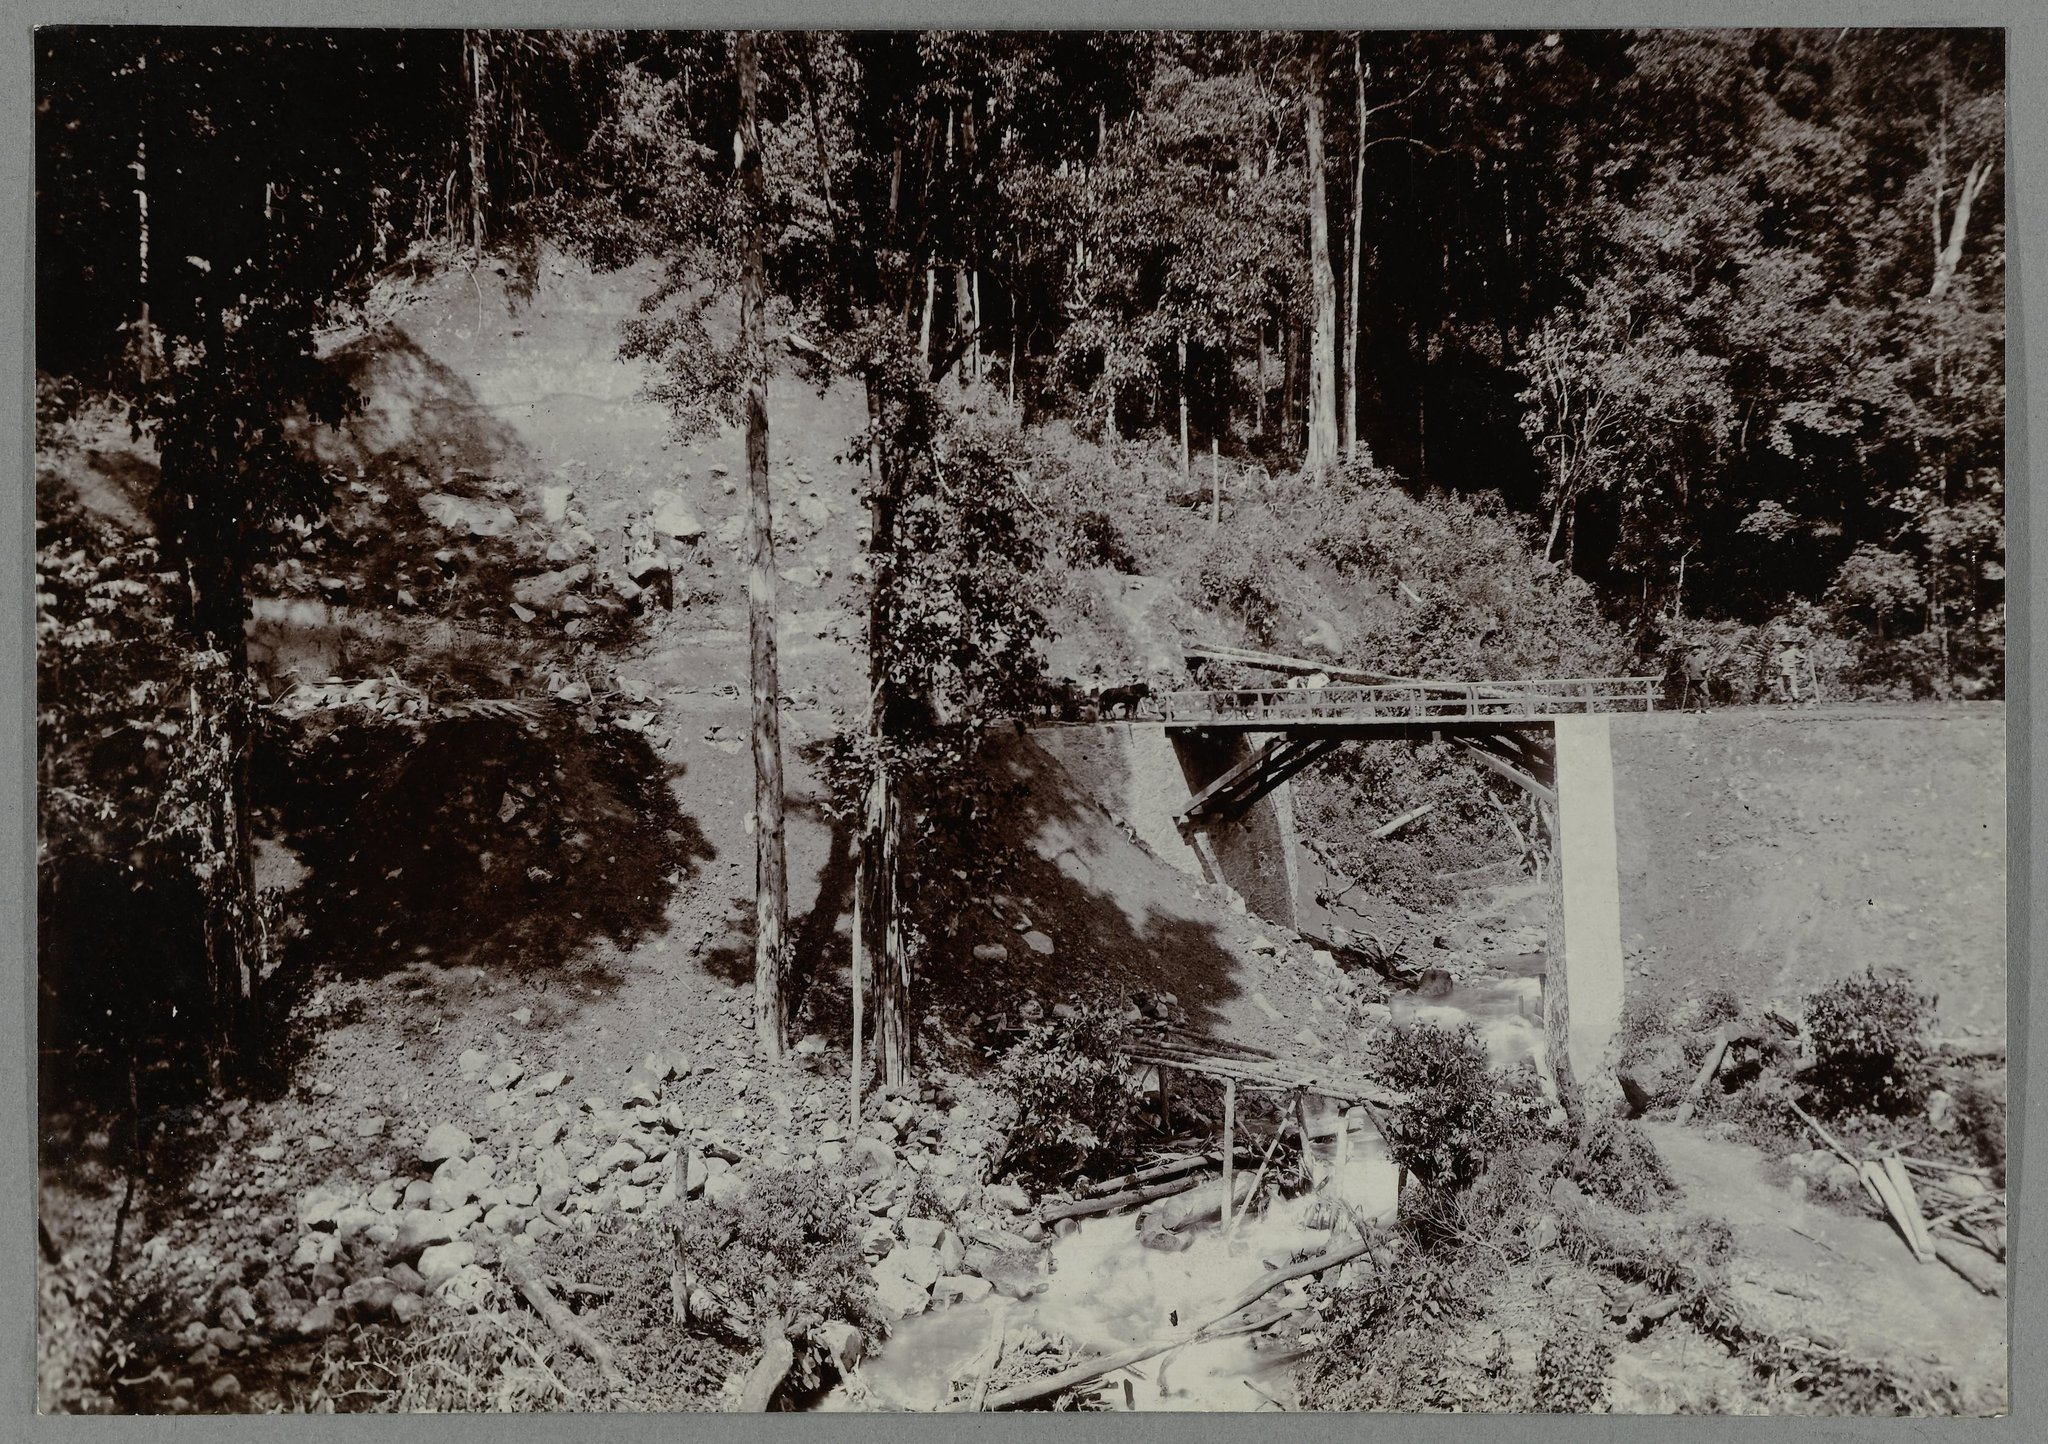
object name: photograph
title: Brug over de Timbang Gadja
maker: Anonymous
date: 1903-1913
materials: photographic support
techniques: photography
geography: north sumatra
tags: arnhem, albertus dominicus laman trip, building activities, traffic by road or path with motor-vehicle, landscapes in tropical and sub-tropical regions, road, path, bridge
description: Na de expedities naar de Gajo- en Alaslanden o.l.v. Van Daalen (eerste tocht in 1901), werd hij in 1903 belast met voorbereiding van permanente vestiging van Nederlands gezag. Aanleg van een weg van de Noordkust naar het binnenland was hierbij van groot belang. Deze zgn. Gajoweg werd aangelegd tussen 1903 en 1914, van Bireuen aan de kust naar Takinguen aan het bergmeer Danau Lauttawar, totale lente 104 km.